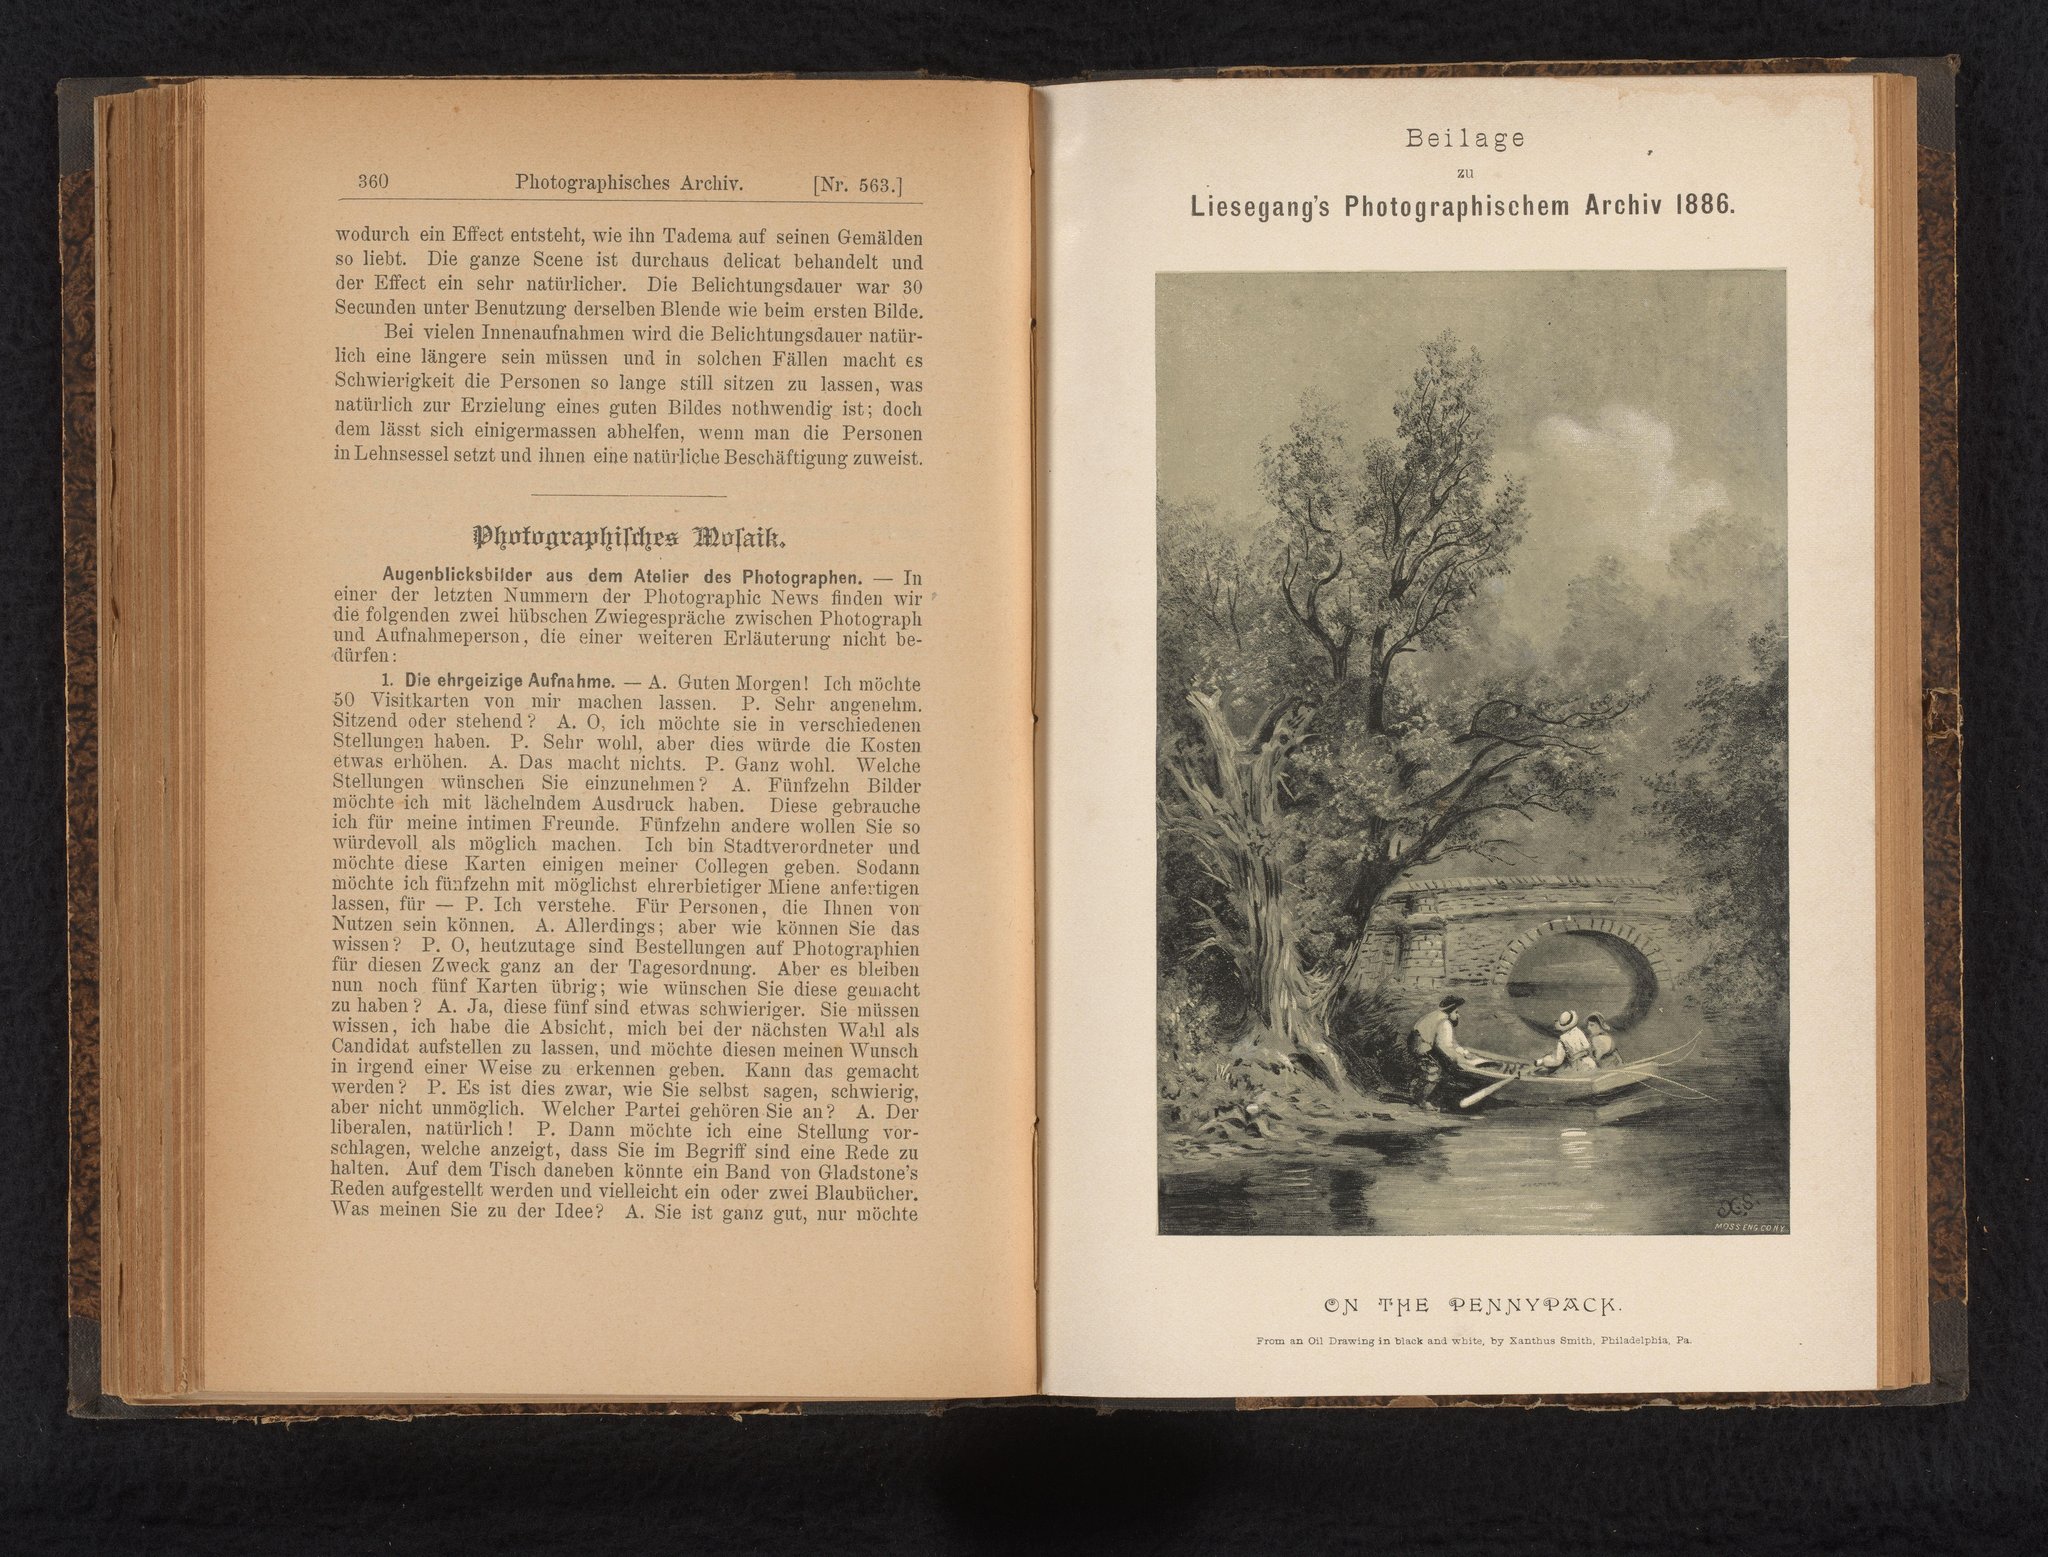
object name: photomechanical print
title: On the Pennypack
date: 1881-1886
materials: paper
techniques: autotype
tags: rowing-boat, canoe, etc., bridge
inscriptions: signature: ‘Moss Eng Co NY’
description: Prent op op ongenummerde pagina tegenover pagina 360.